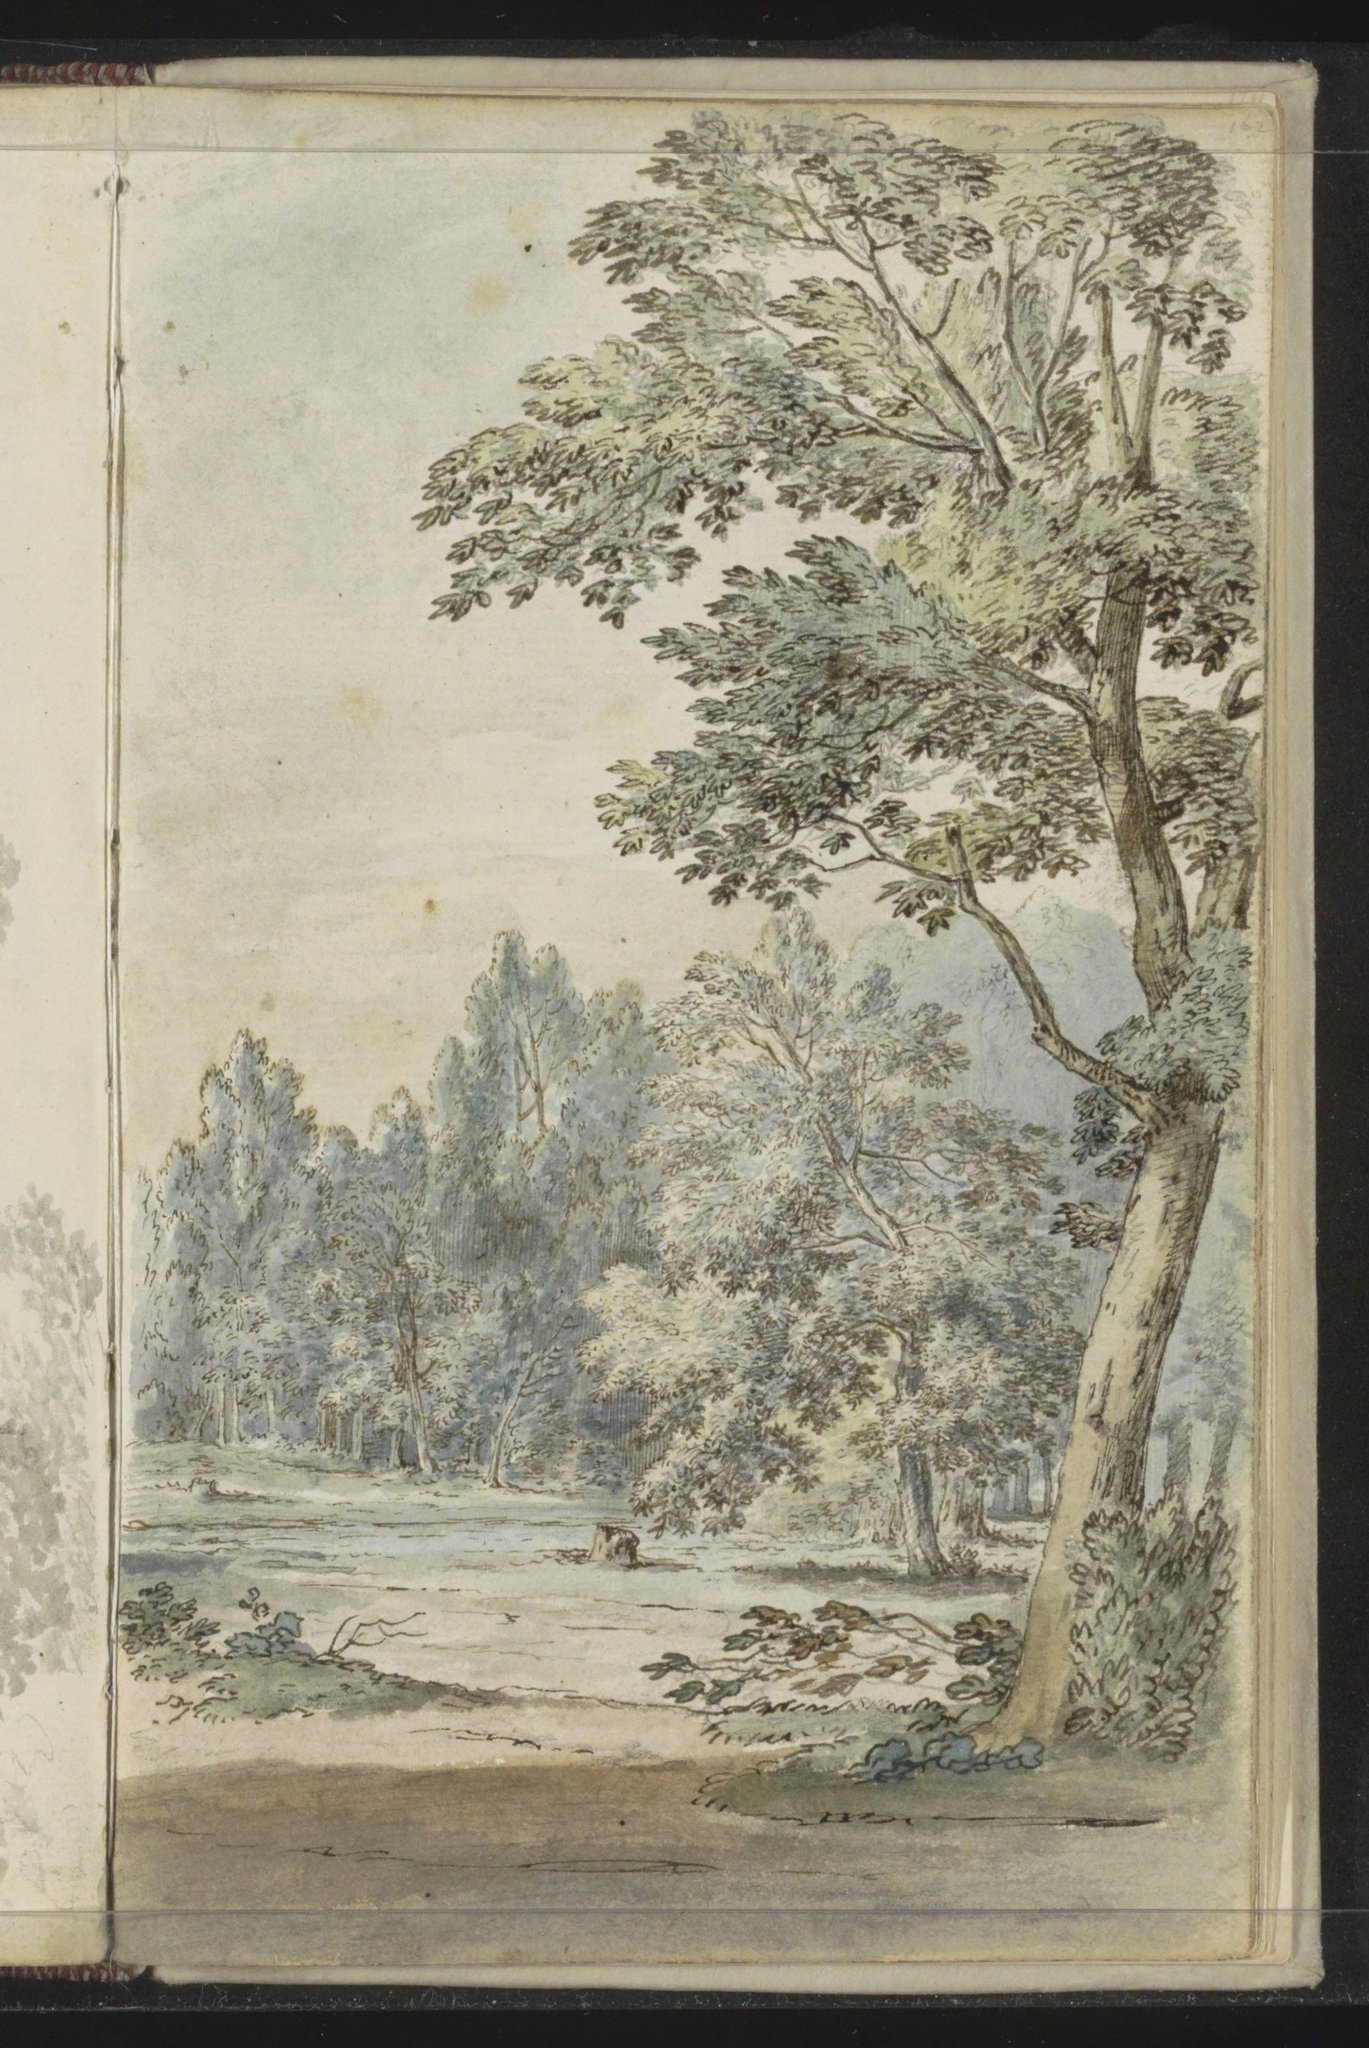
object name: sketchbook leaf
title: Open plek in een bos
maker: johannes huibert prins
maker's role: draughtsman, painter, print maker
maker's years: 1757-1806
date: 1783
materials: ink, paper, pencil, watercolor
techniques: brush, pen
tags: clearing ~ forest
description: Pagina 162 uit een schetsboek met 175 pagina's.